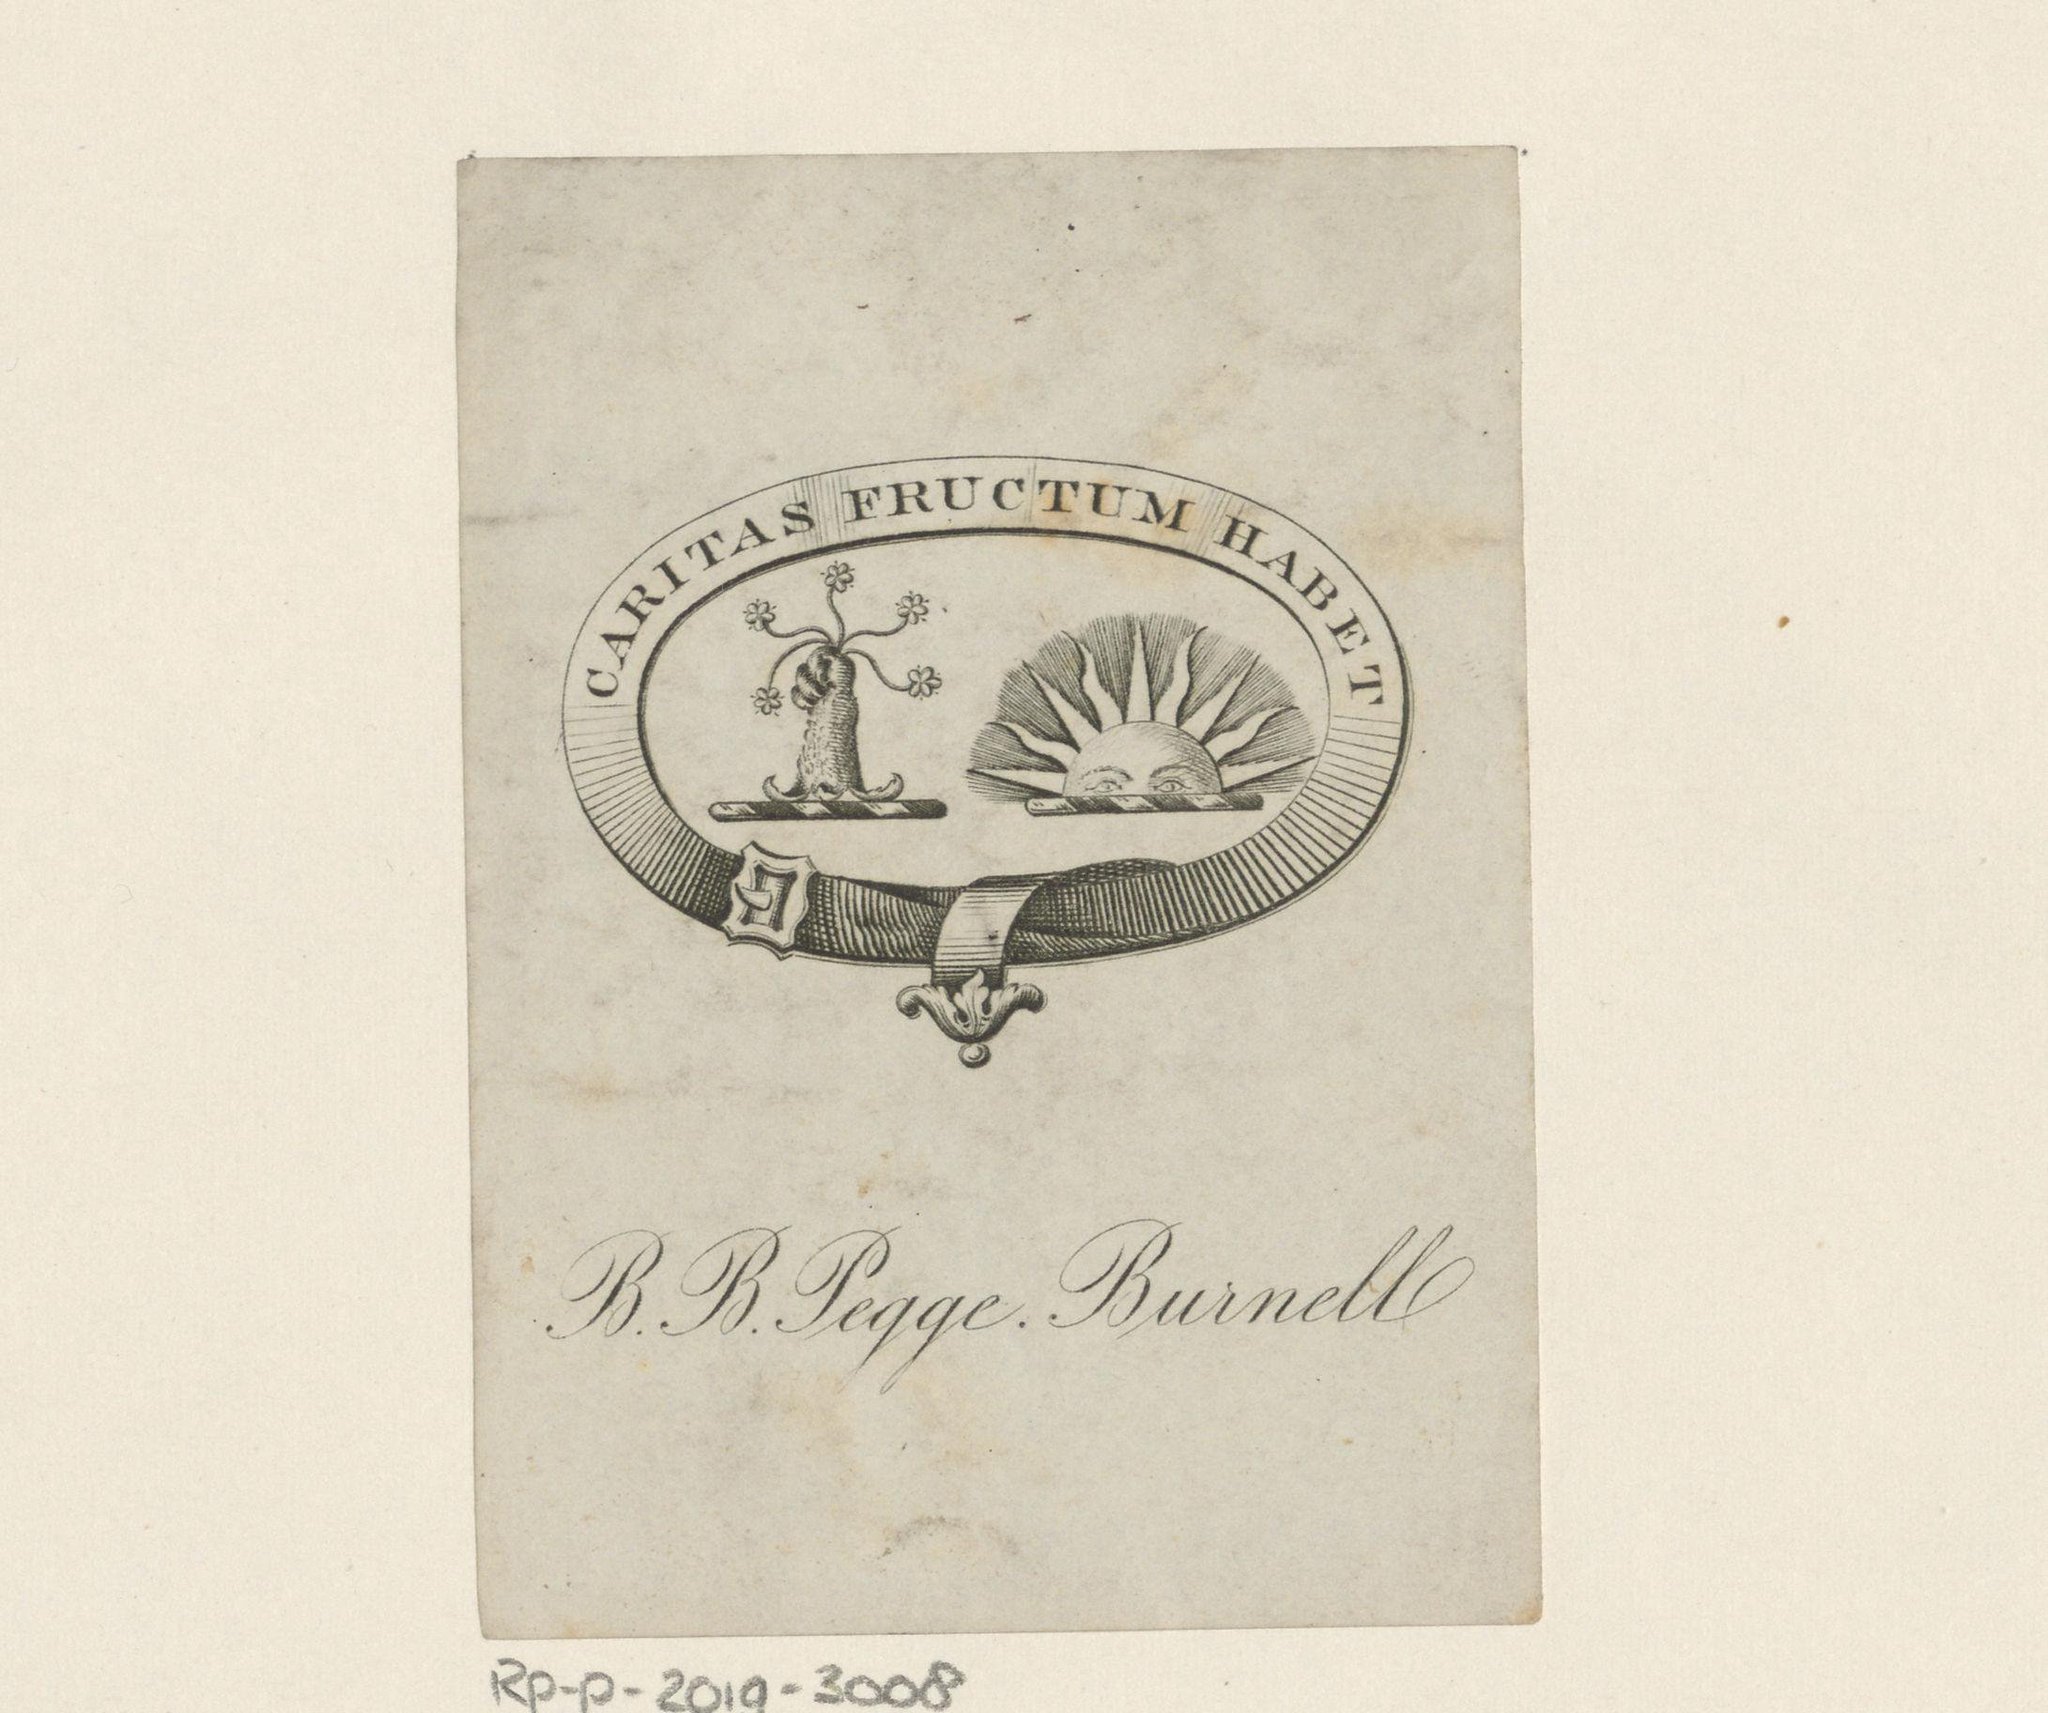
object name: bookplate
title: Ex libris van B.B. Pegge. Burnell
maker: Anonymous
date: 1800-1899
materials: paper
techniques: engraving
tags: armorial bearing, heraldry